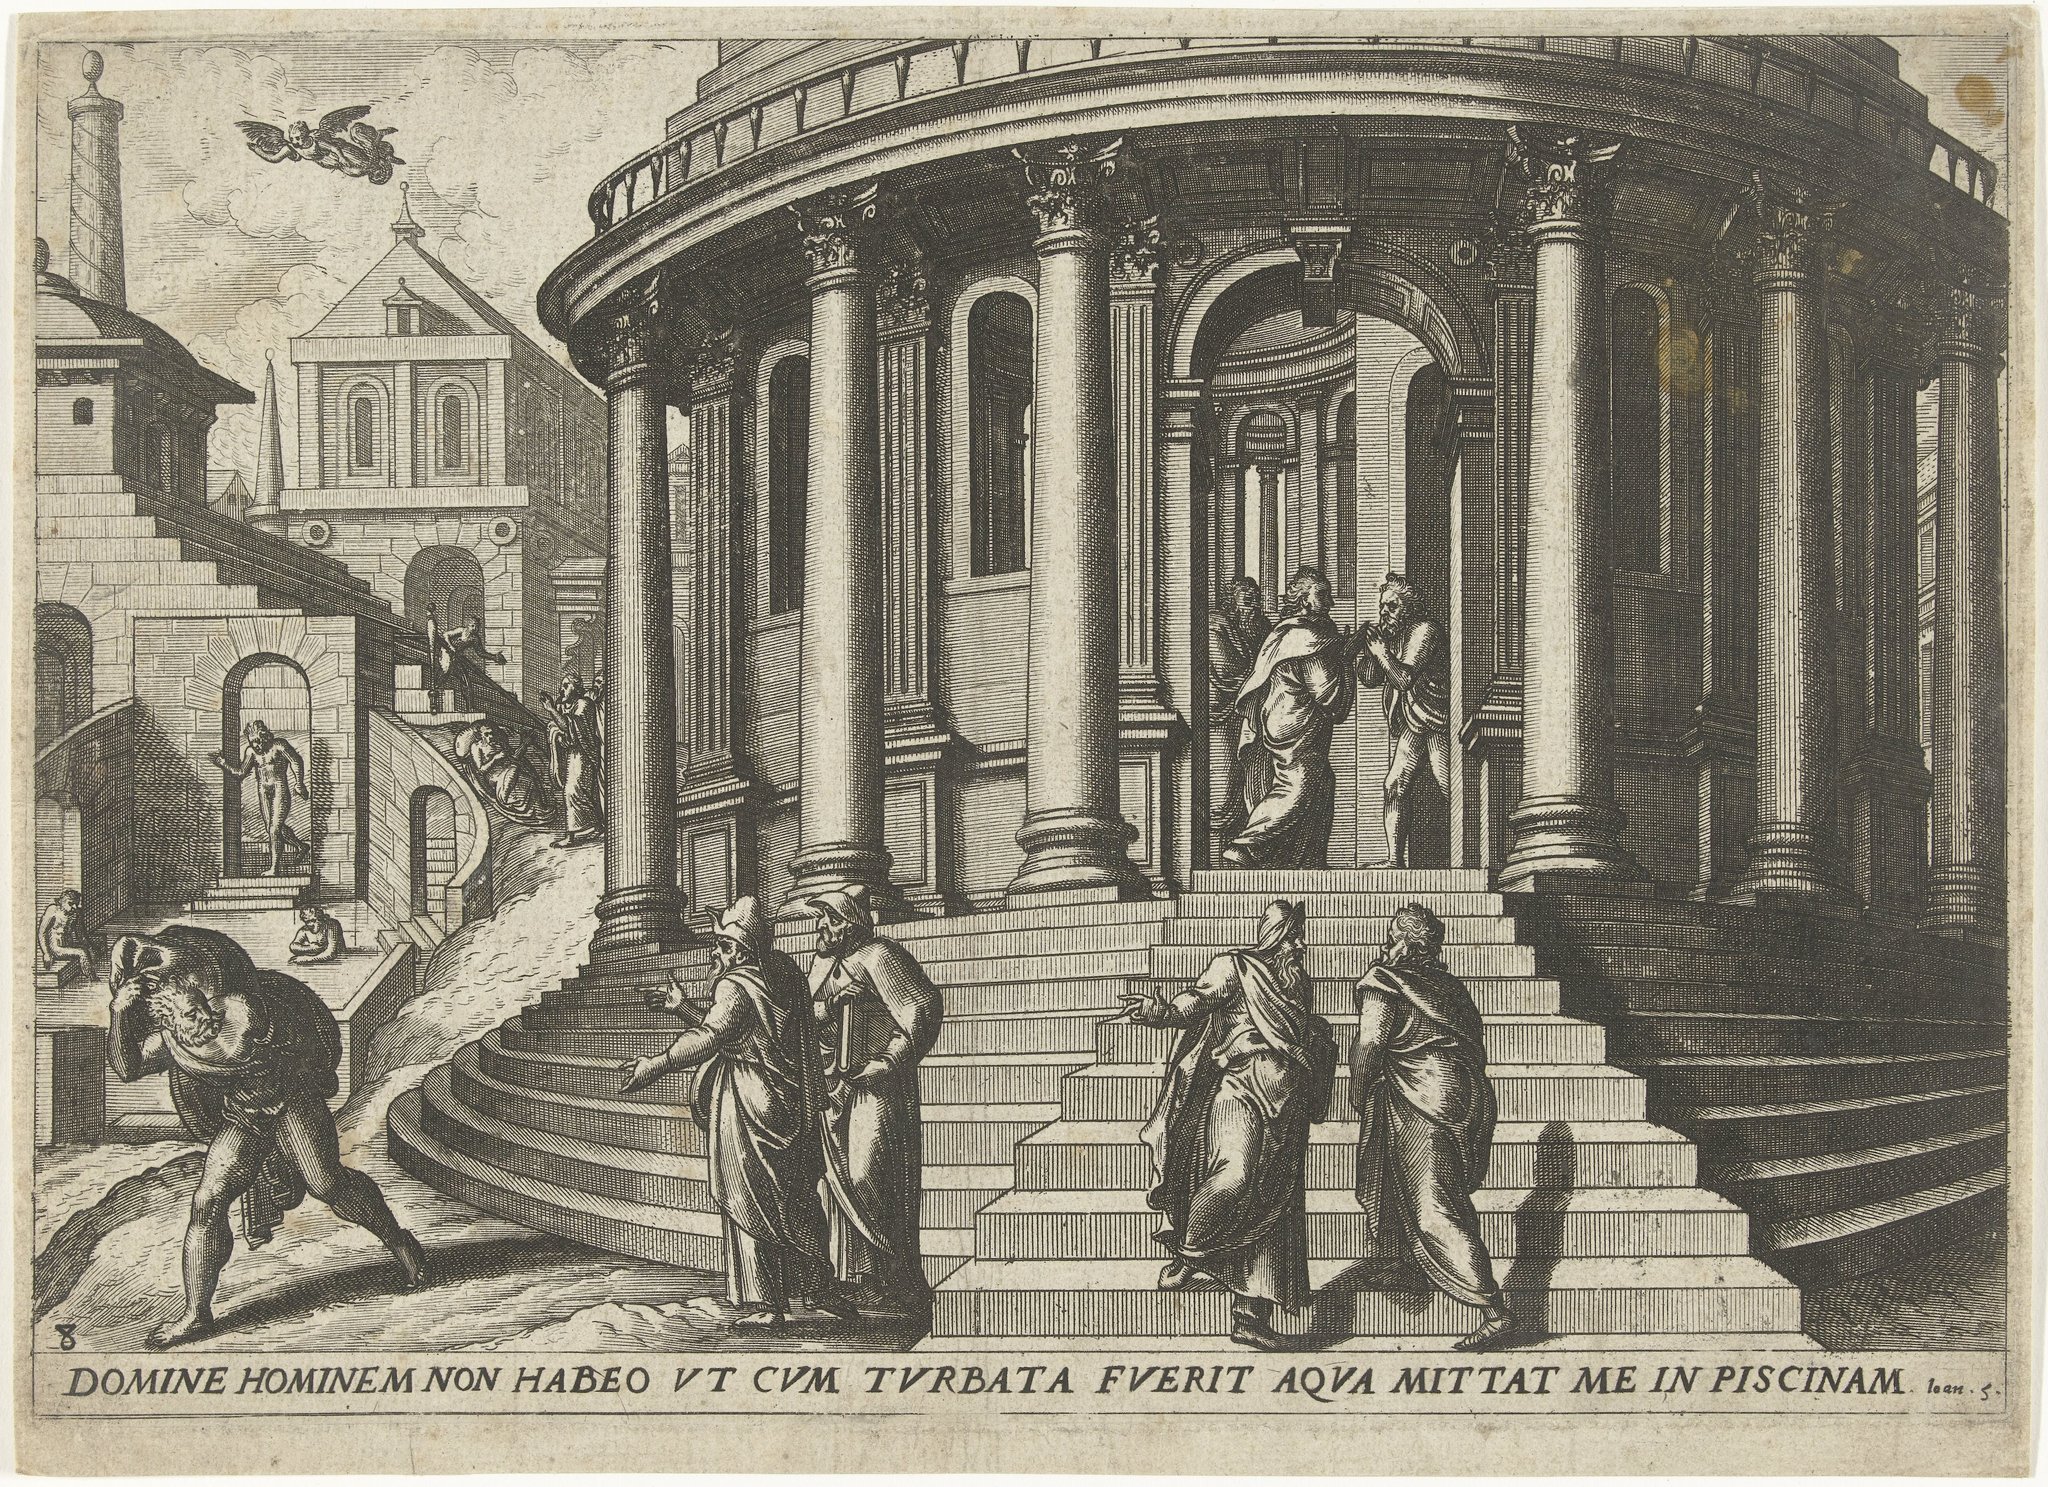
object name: print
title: Memorabilivm Novi Testamenti in templo gestorvm icones tredecim elegantissimi ac ornatissimi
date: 1572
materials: paper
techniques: engraving, etching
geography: antwerp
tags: christ says to a paralytic man: 'rise, take up your pallet (bed)', the paralytic man is cured and walks away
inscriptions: collector's mark: Lugt 2228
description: Christus loopt op sabbat langs het bad van Betzata waar veel zieken liggen. Hij geneest een zieke man die vervolgens weer kan lopen en met zijn slaapmat wegloopt. De omstanders kijken hem verbaast naar.